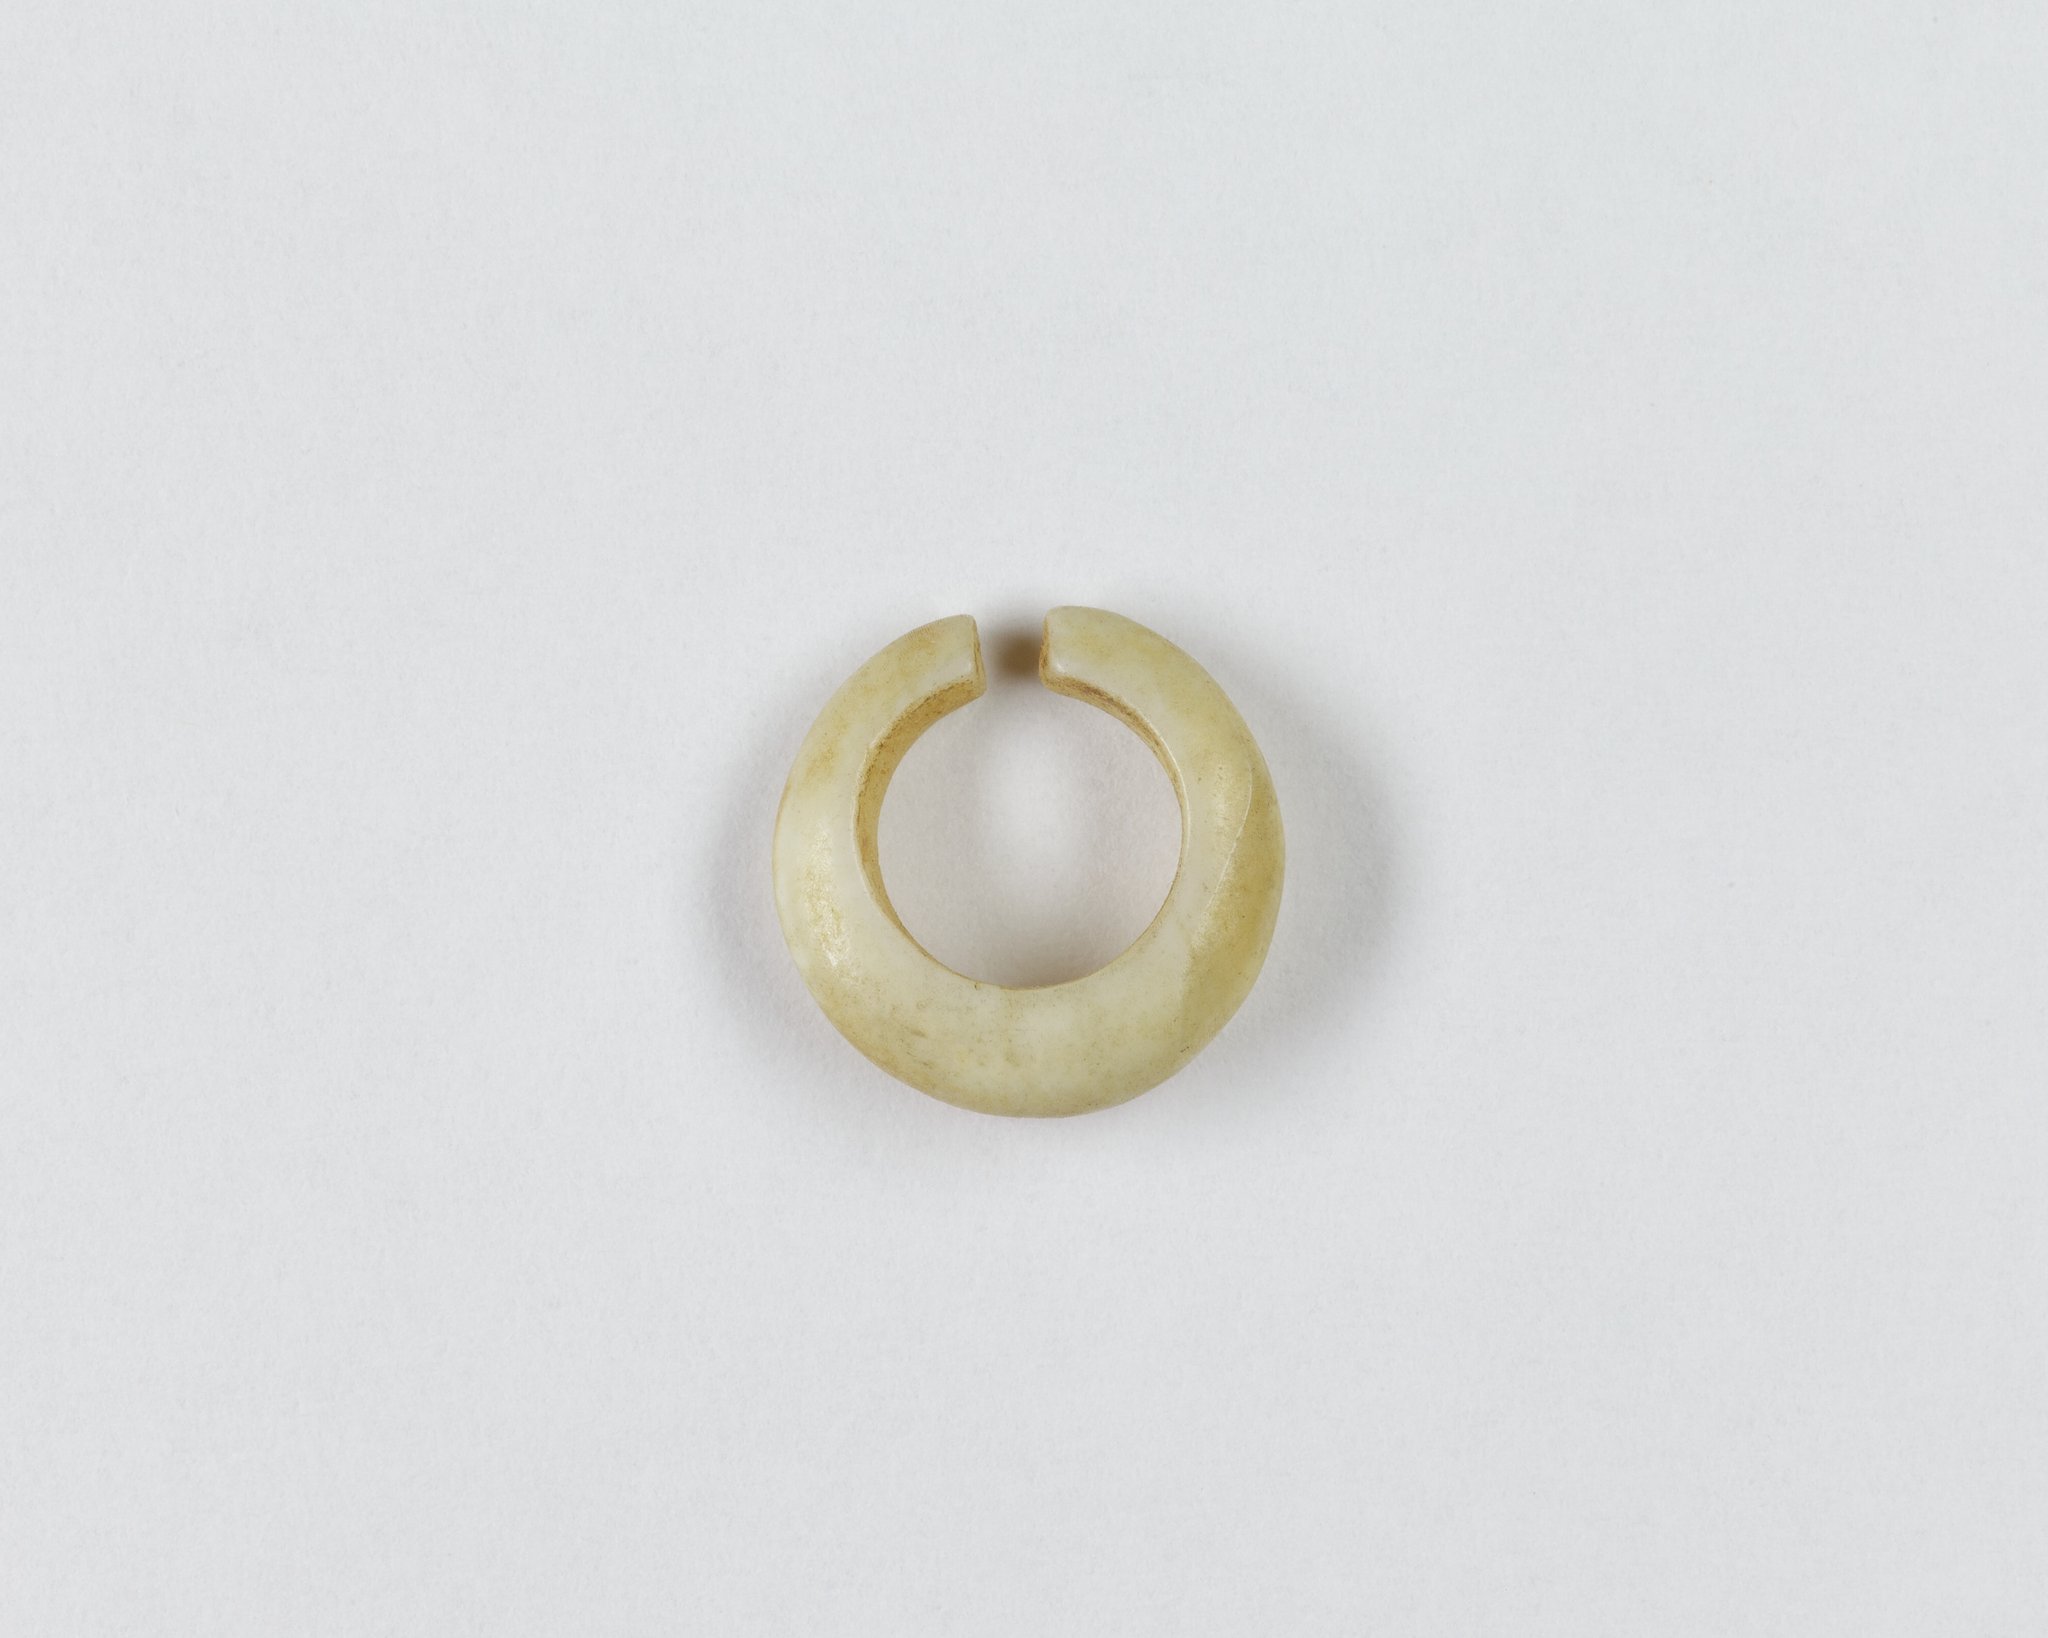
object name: earring, penannular, circular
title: Penannular Earring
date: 1550-1295 BCE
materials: shell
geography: northern upper egypt